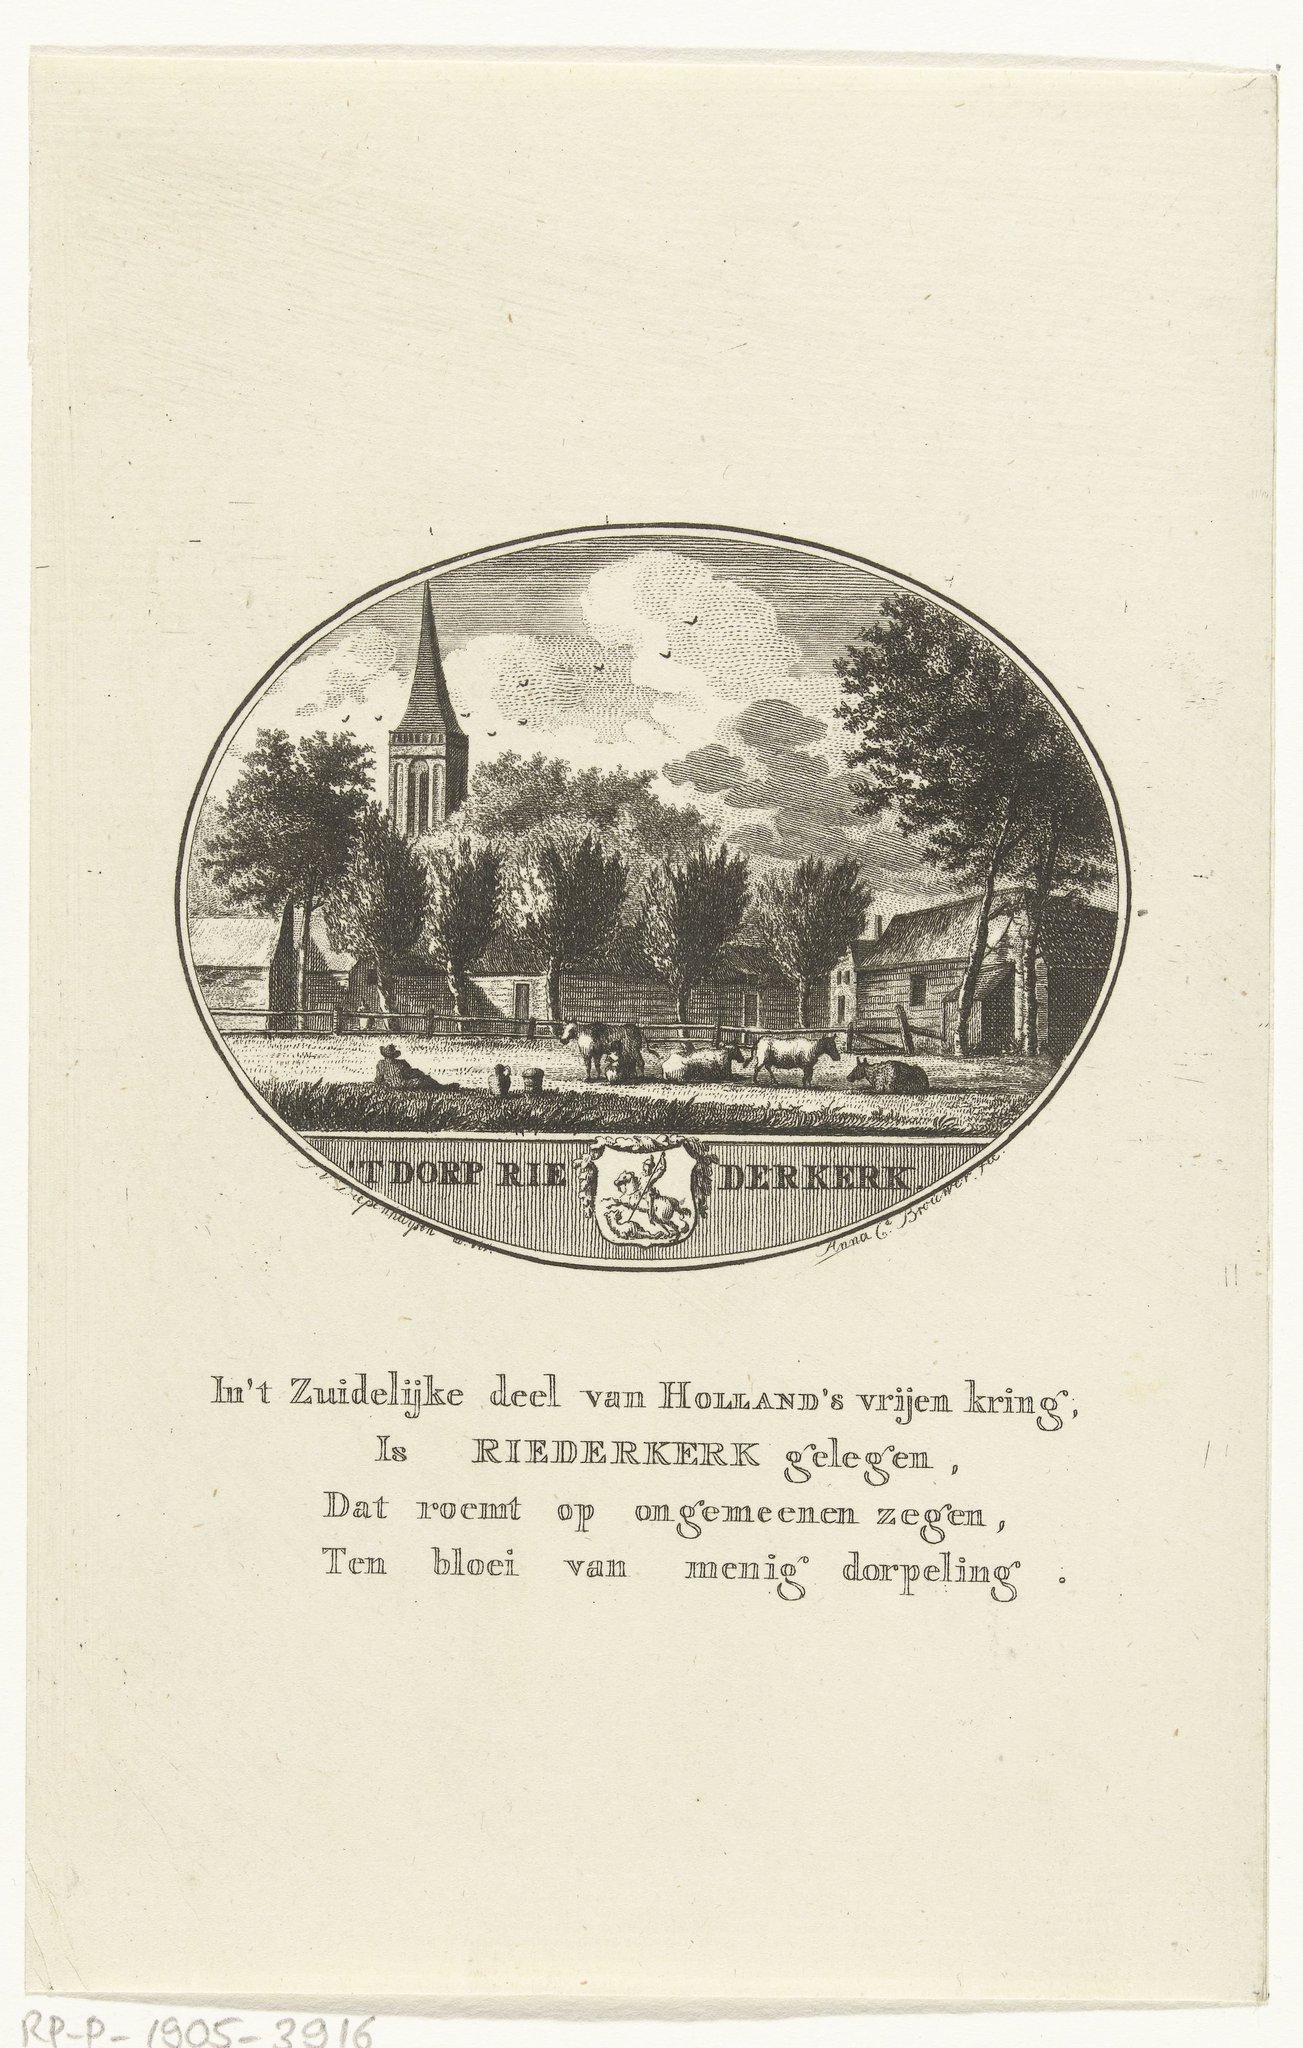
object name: book illustration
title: 't Dorp Riederkerk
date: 1791-1793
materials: paper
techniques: etching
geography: amsterdam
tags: city-view in general; 'veduta', village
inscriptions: collector's mark: Lugt 2228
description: afkomstig uit: L. van Ollefen, De Nederlandsche stad- en dorpbeschrijver. Deel 1. Amsterdam: H.A. Banse, 1793